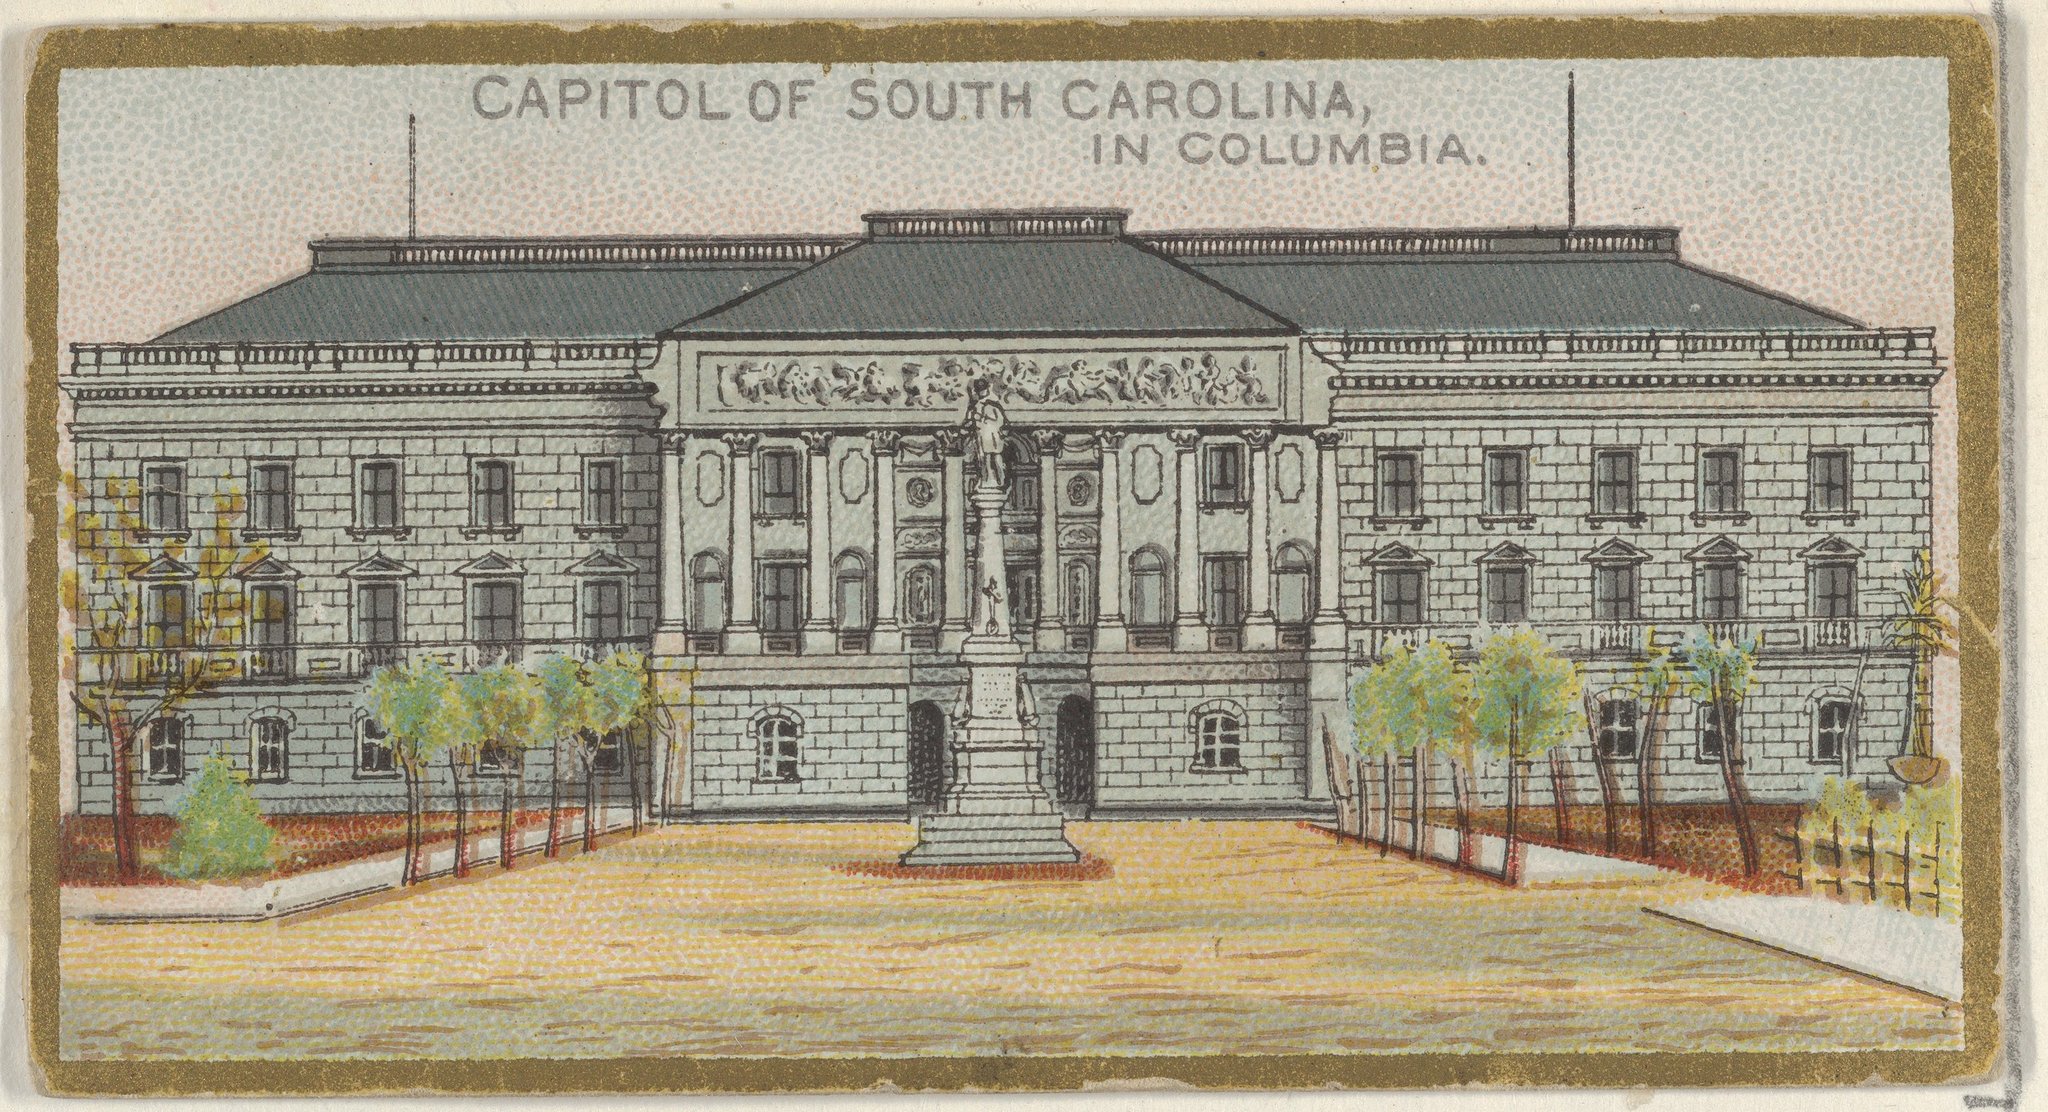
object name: print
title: Capitol of South Carolina in Columbia, from the General Government and State Capitol Buildings series (N14) for Allen & Ginter Cigarettes Brands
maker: allen & ginter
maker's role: publisher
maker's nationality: american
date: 1889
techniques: color lithograph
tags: buildings